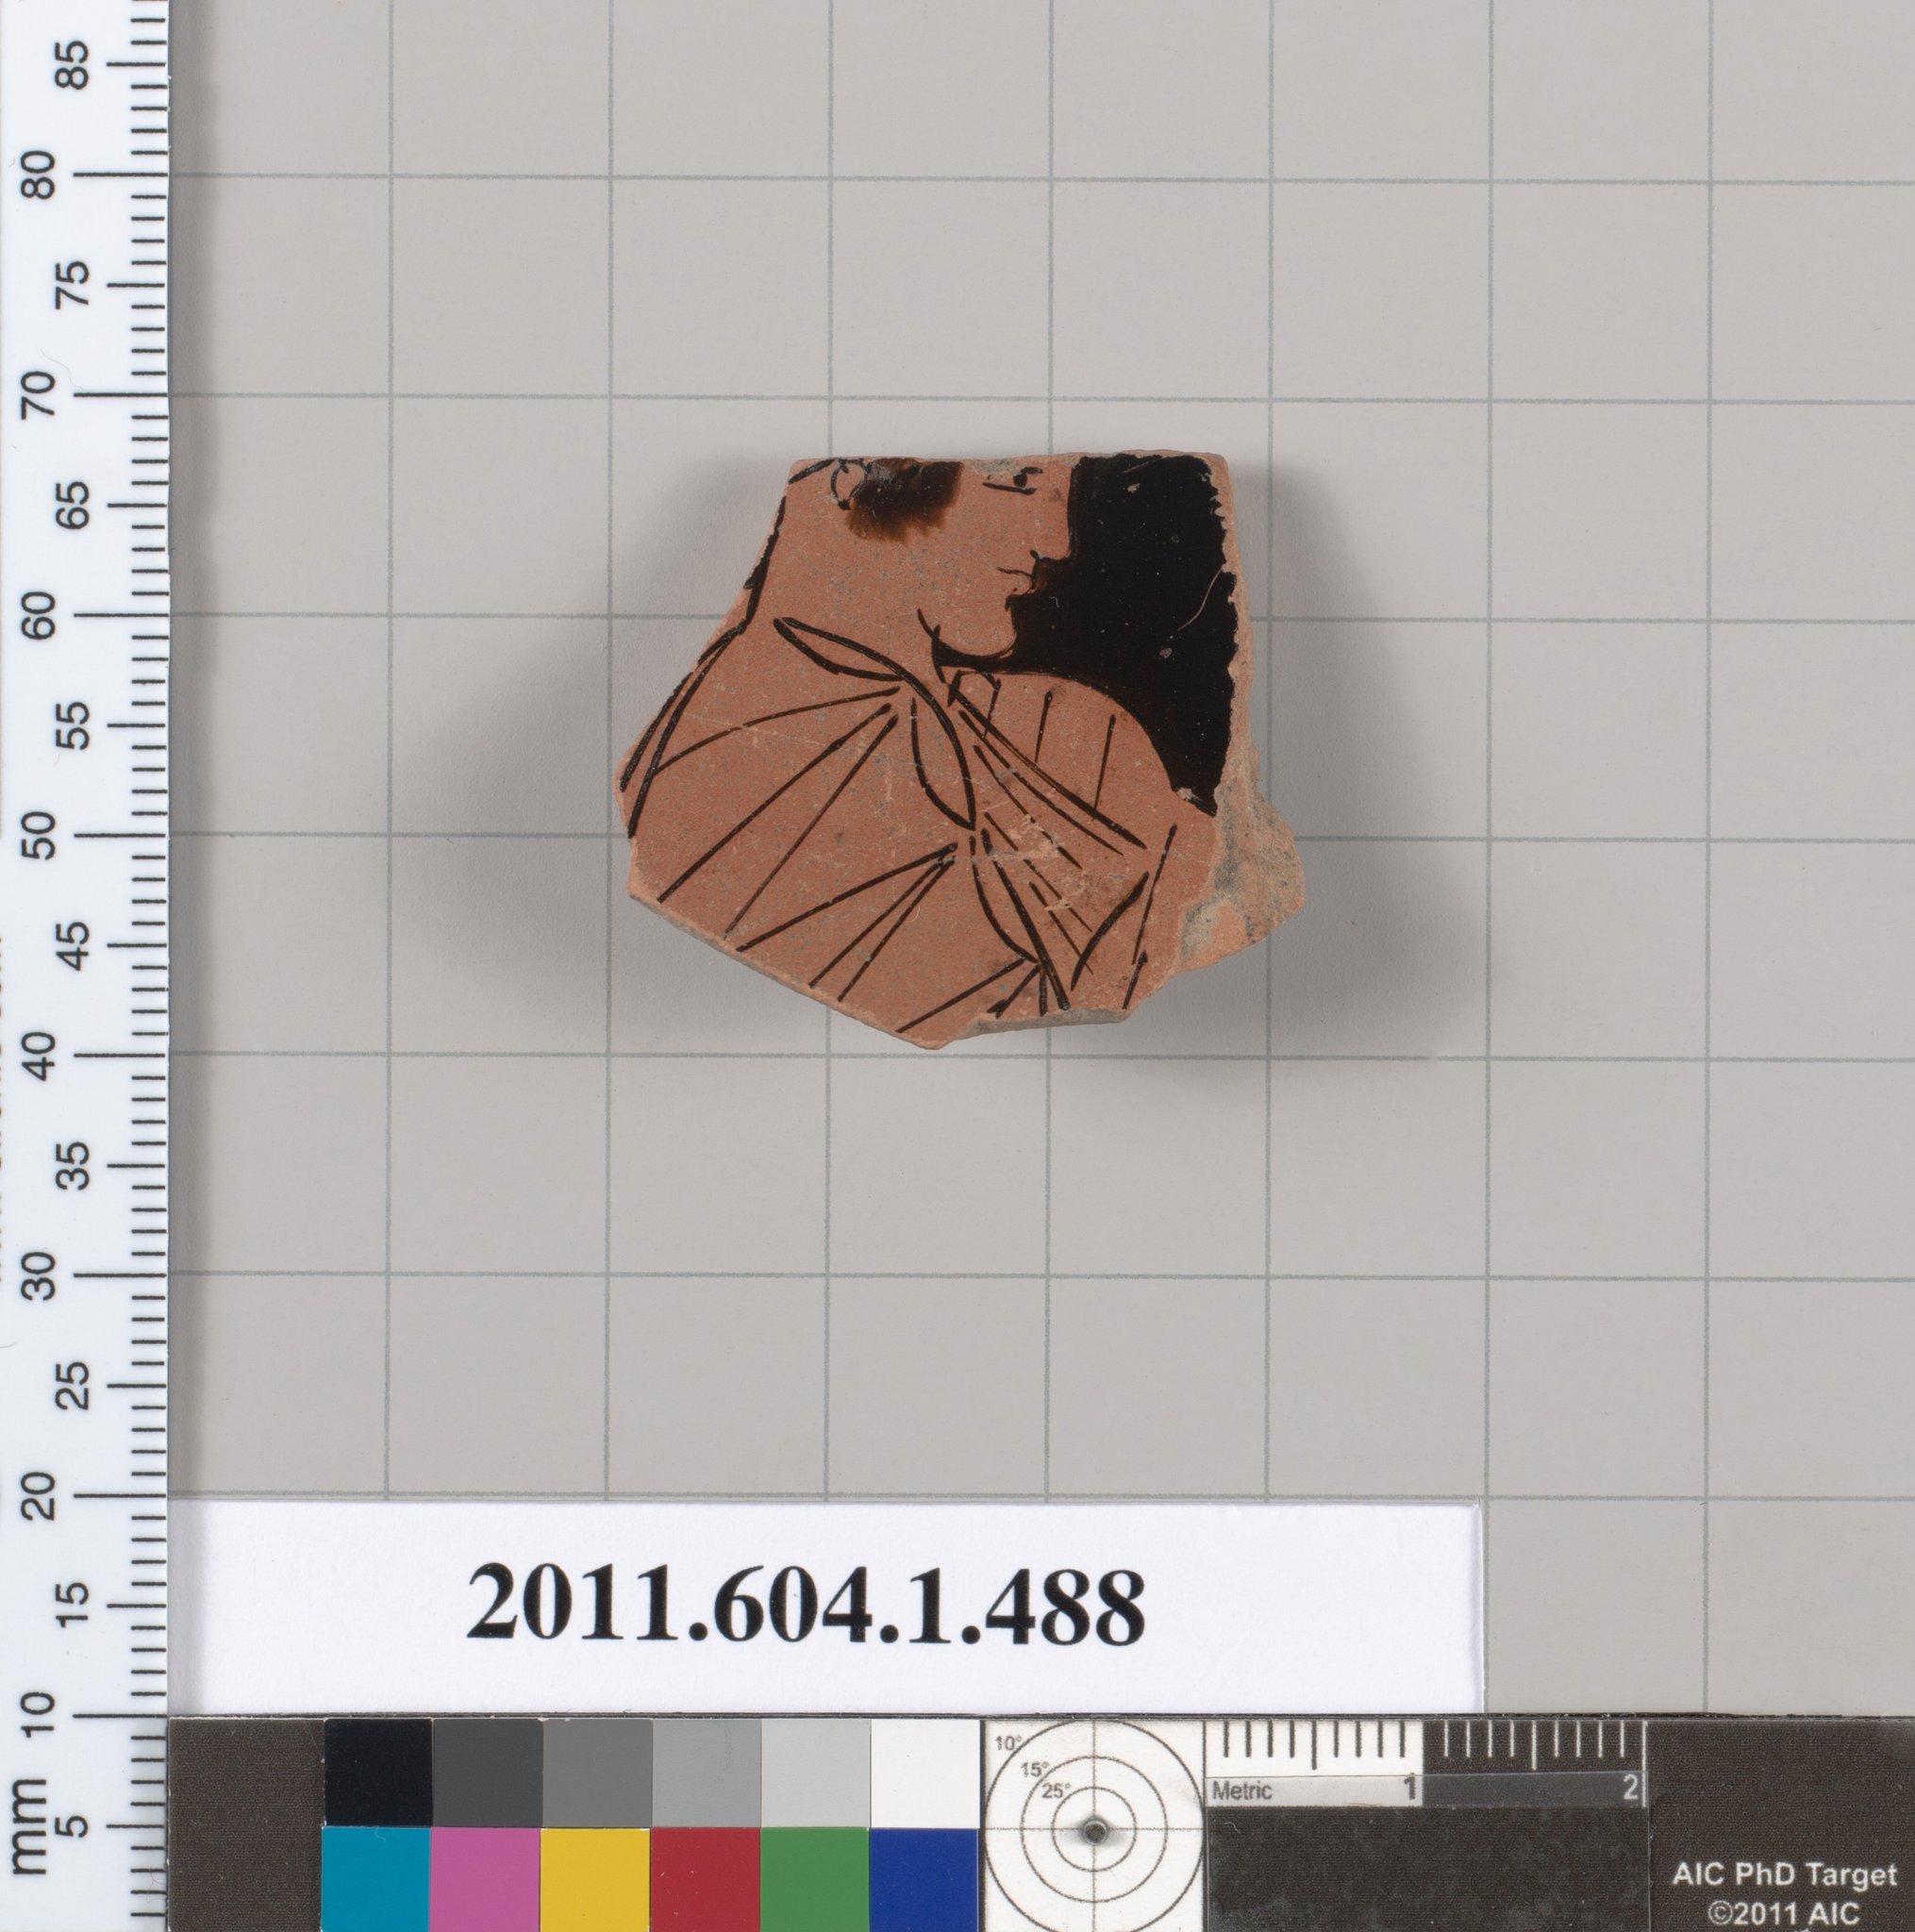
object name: kylix fragment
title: Terracotta fragment of a kylix (drinking cup)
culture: greek, attic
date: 475-451 BCE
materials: terracotta